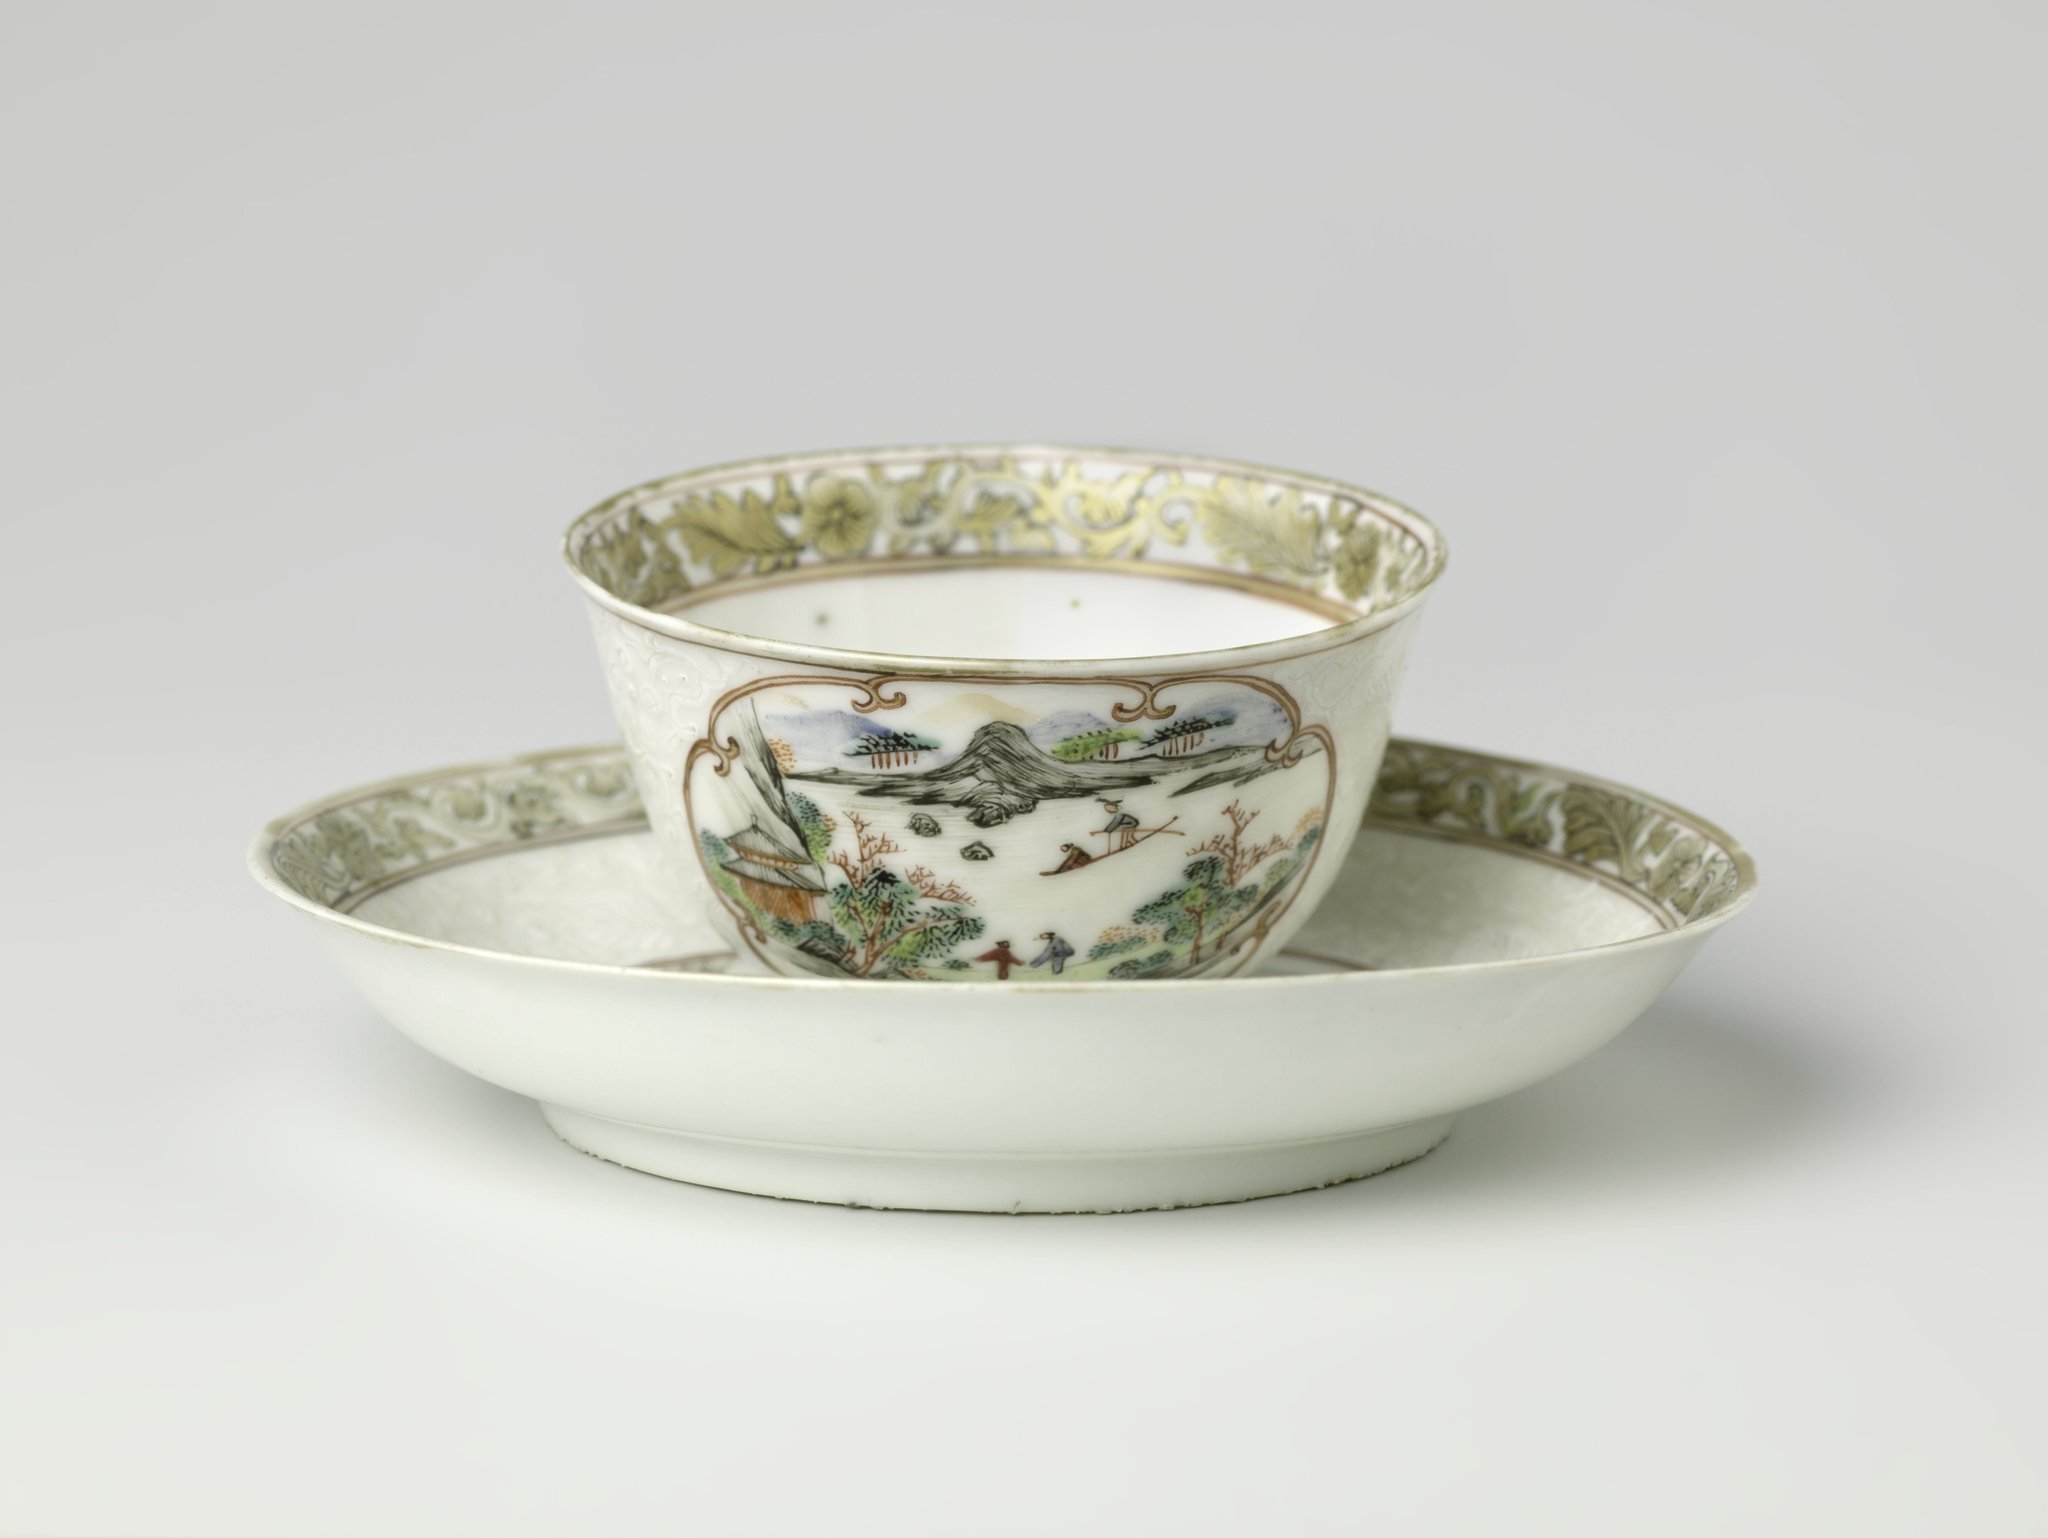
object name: kop en schotel, kop en schotel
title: Bell-shaped cup and saucer with a water landscape and floral scrolls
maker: Anonymous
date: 1725-1749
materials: glaze, gold, paint, porcelain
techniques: firing, gilding, turning, vitrification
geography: china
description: Klokvormige kop en schotel van porselein, beschilderd op het glazuur in blauw, rood, roze, groen, zwart en goud. Op het plat van de schotel een gelobd cartouche met hierin een rivierlandschap met paviljoen, personen, bomen en rotsen, om het cartouche bloemranken in bianco sopra bianco; de binnenrand met een band met bloemranken. De kop met dezelfde decoratie. Famille rose.